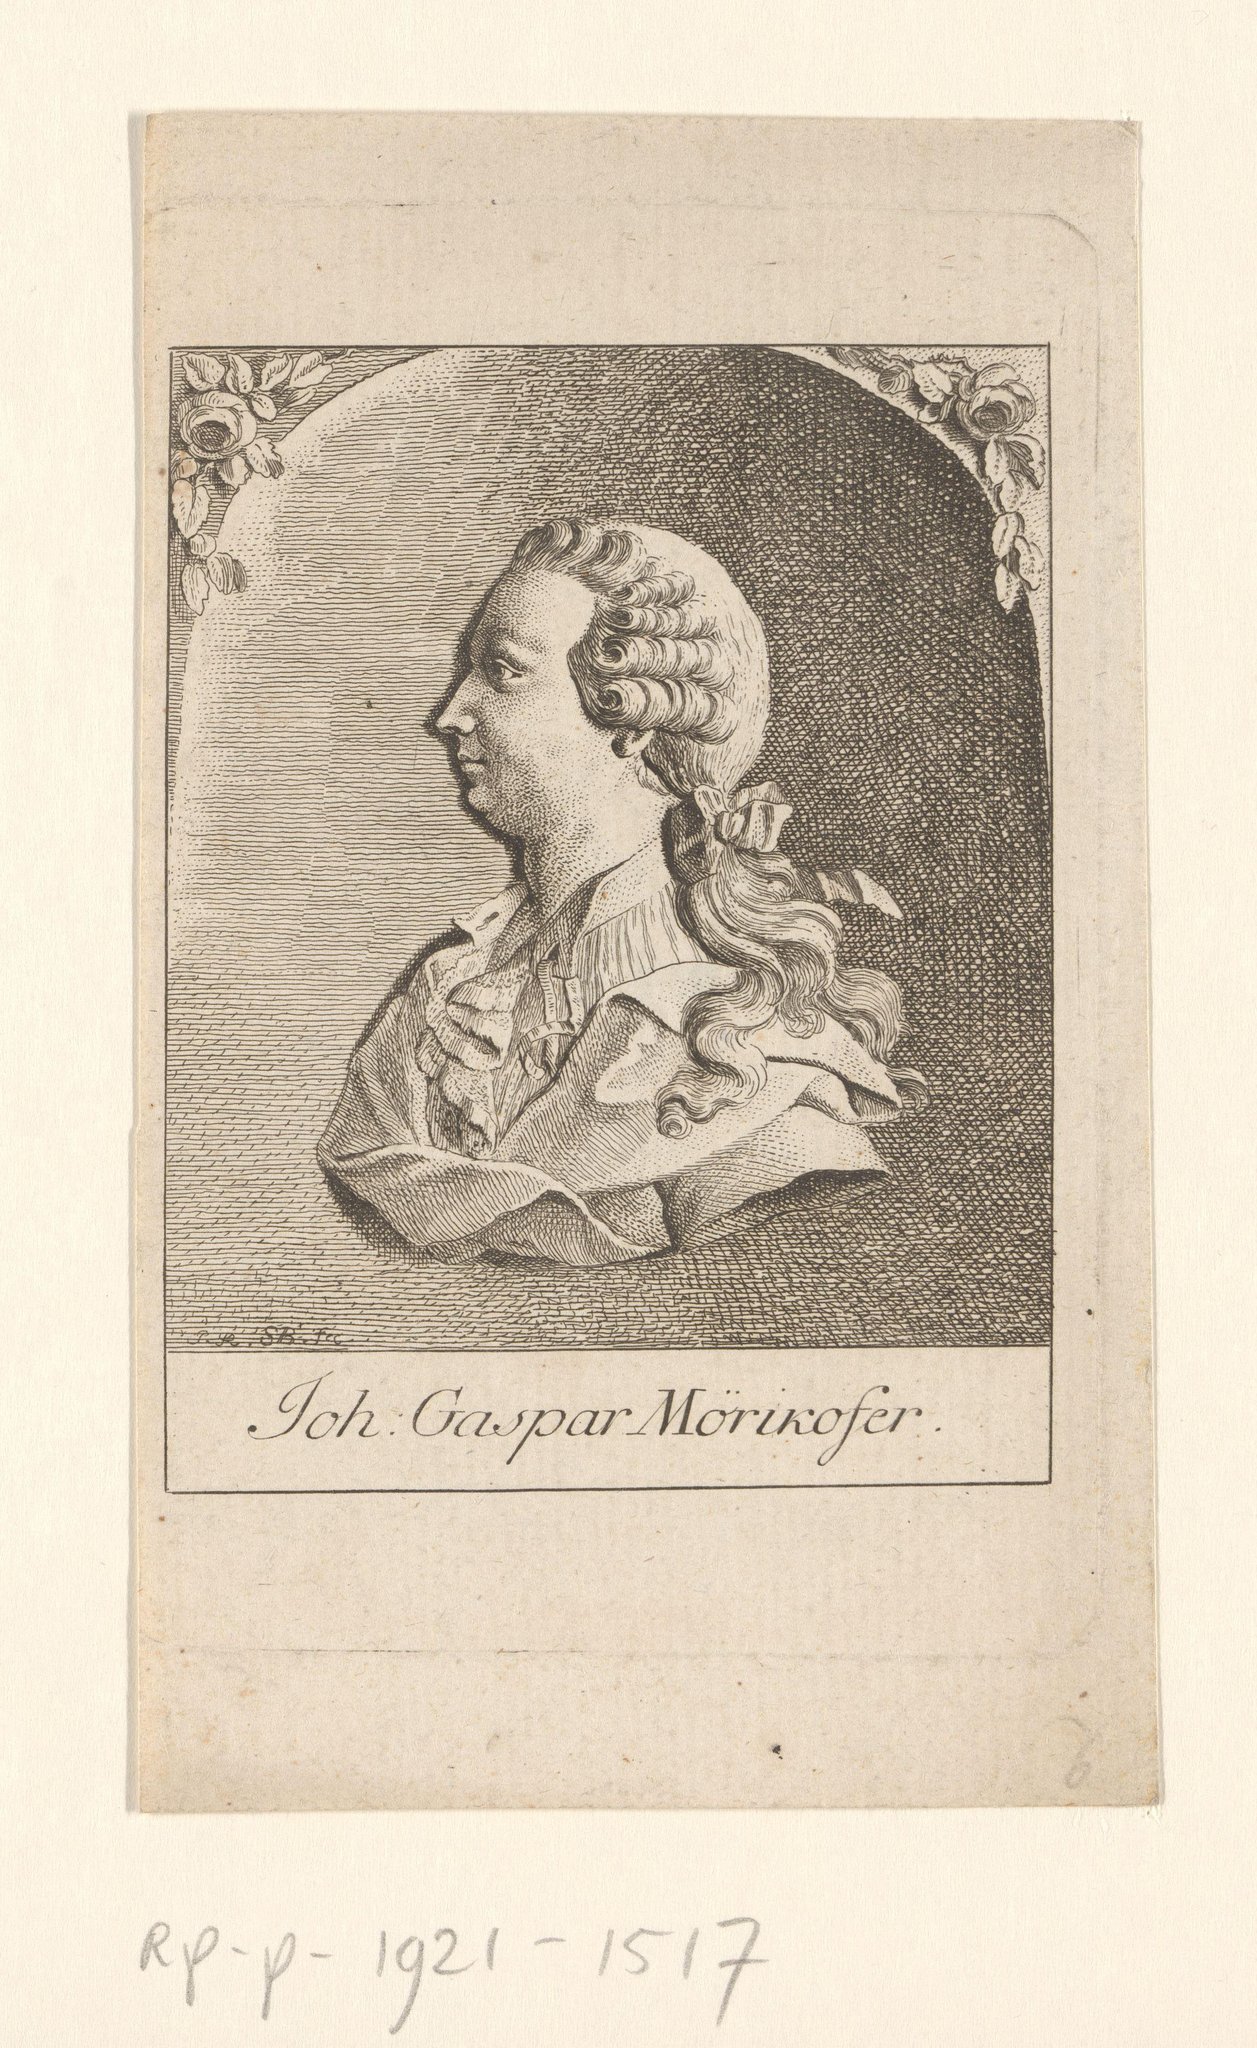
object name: print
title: Portret van Johann Kaspar Mörikofer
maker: johann rudolph schellenberg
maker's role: print maker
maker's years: 1740-1806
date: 1750-1806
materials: paper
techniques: etching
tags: historical persons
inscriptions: collector's mark: Lugt 2233